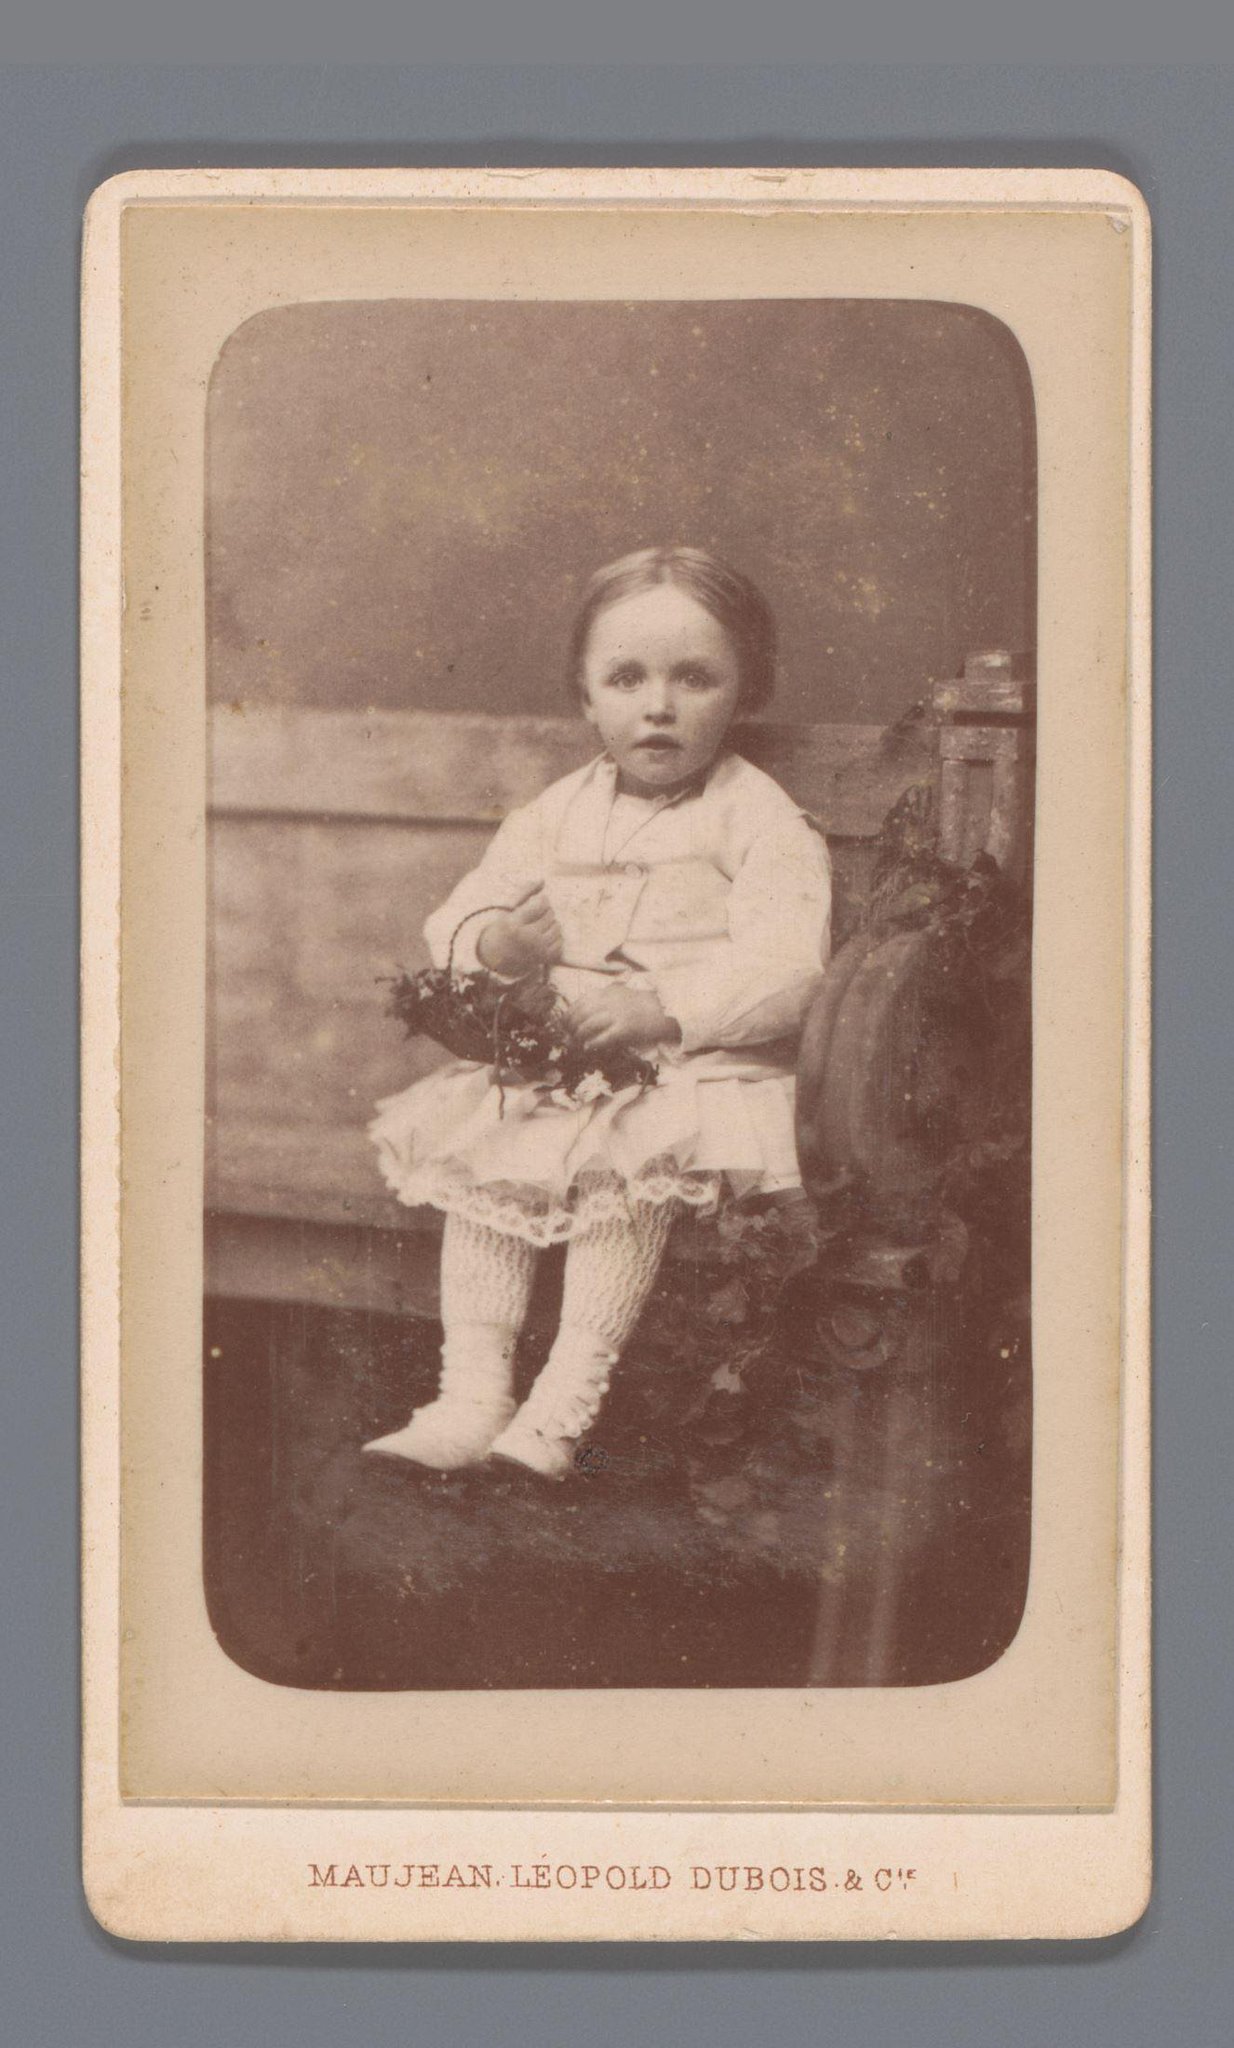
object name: photograph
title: Portret van een onbekend meisje met een bloemenmandje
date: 1808-1881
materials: cardboard, celluloid, paper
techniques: albumen print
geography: paris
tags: historical persons, girl (child between toddler and youth)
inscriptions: inscription: ‘86788’, inscription: ‘Affectionnate Souvenir/ august 1881 af.’, inscription: ‘PHOTOGRAPHIE MAUJEAN DUBOIS/ ALPHONSE THOMAS/ ET CIE/ 30 Rue du Faubourg St Honoré/ 35, Rue de Boissy d'anglas/ Cité du Retiro, 19./ PARIS/ 80.000 CLICHÉS CONSERVÉS/ English Spoken.’